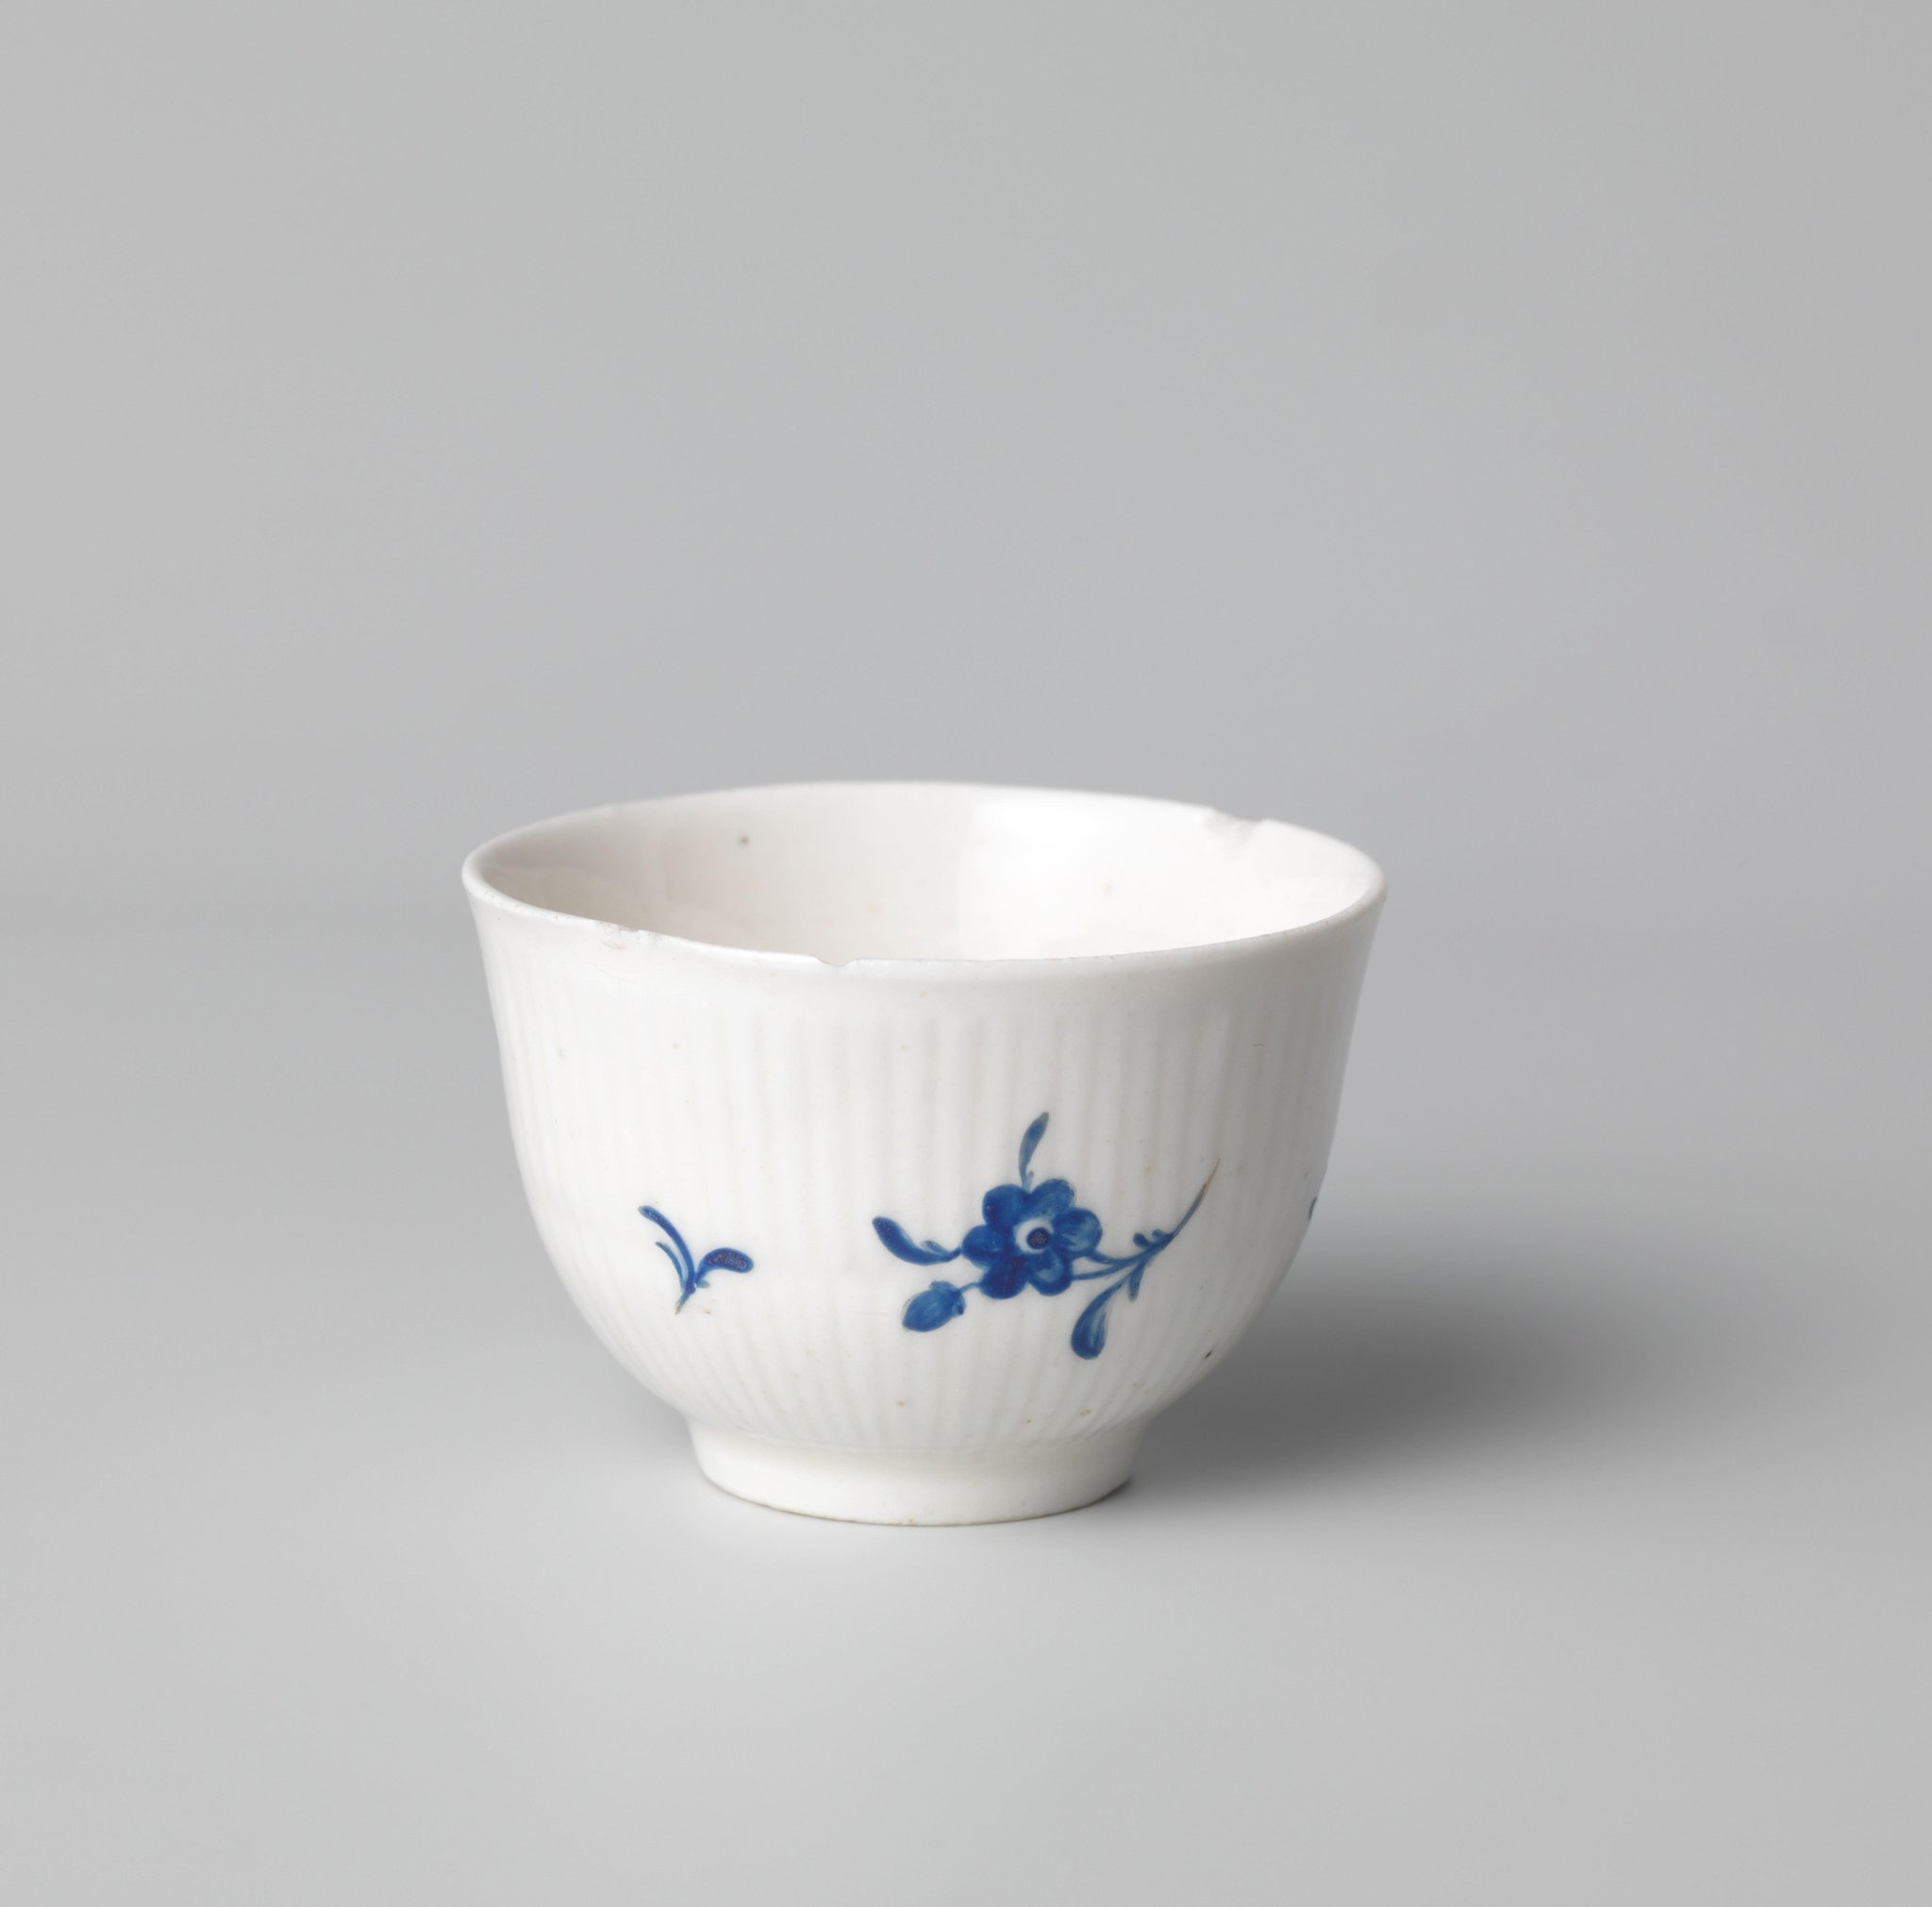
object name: cup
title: Kop, beschilderd met strooibloemen en bladeren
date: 1780-1784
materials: porcelain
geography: loosdrecht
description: Kop zonder oor, van porselein, beschilderd met strooibloemen en bladeren in blauw.